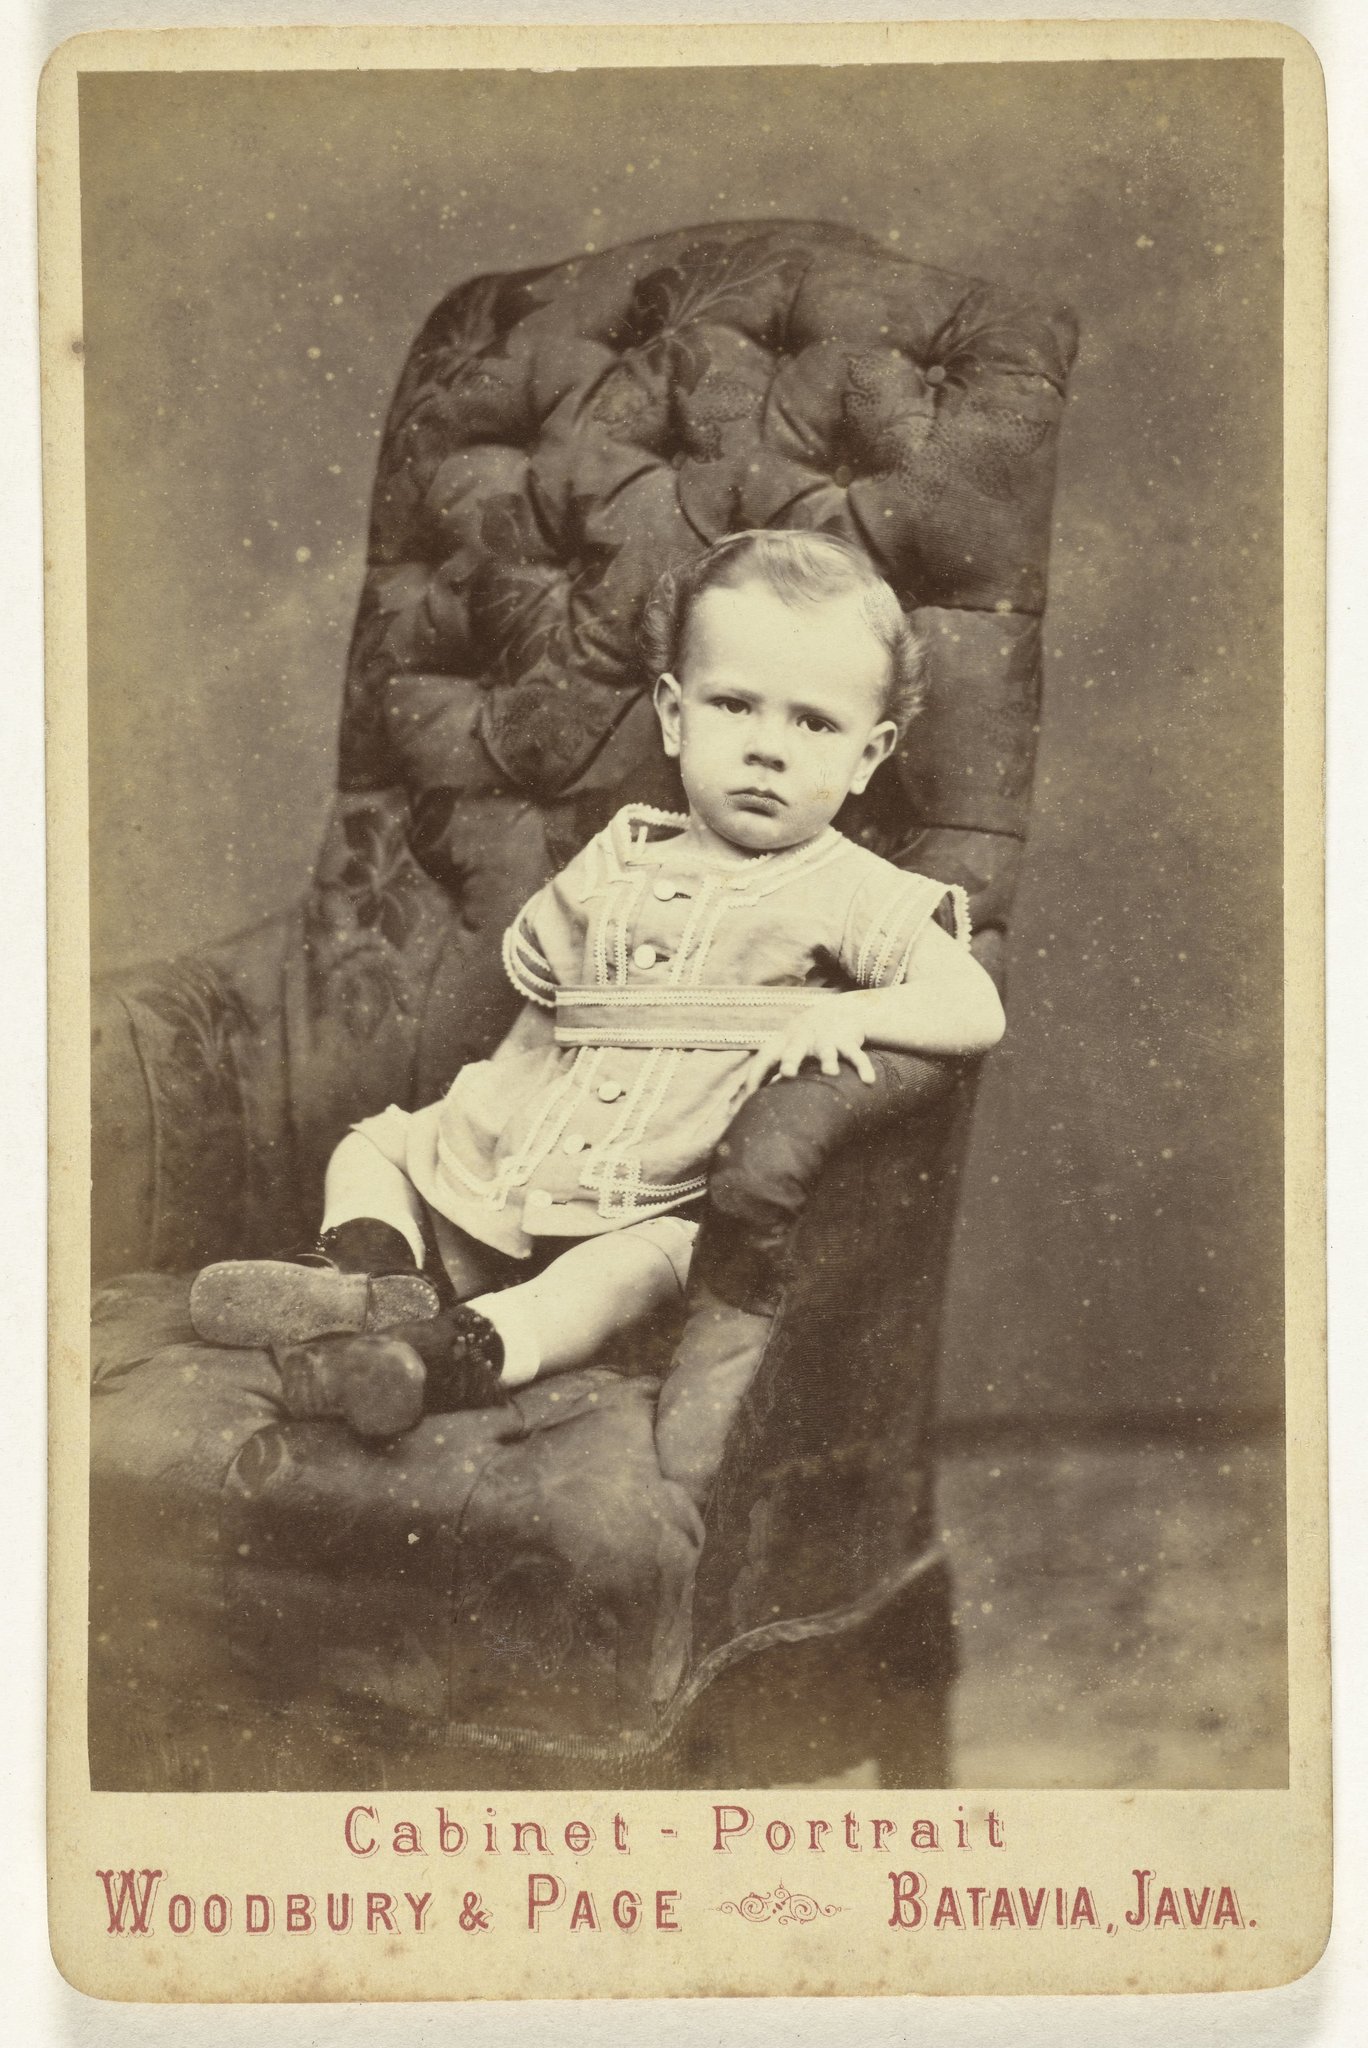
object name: photograph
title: Studioportret van H. de Lange als klein kind zittend in een stoel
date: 1890-1910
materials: paper, photographic support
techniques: photography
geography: batavia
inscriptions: name: ‘Cabinet Portrait Woordbury & Page Batavia Java’, inscription: ‘H. de Lange’